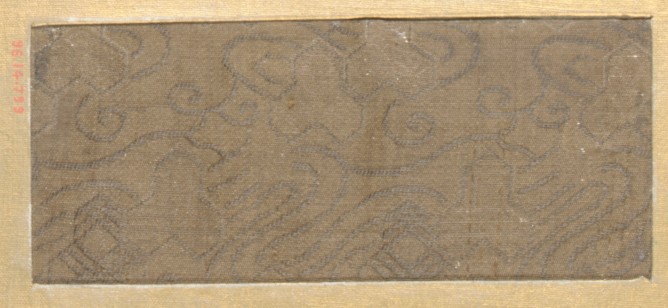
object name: piece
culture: japanese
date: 1701-1900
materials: silk